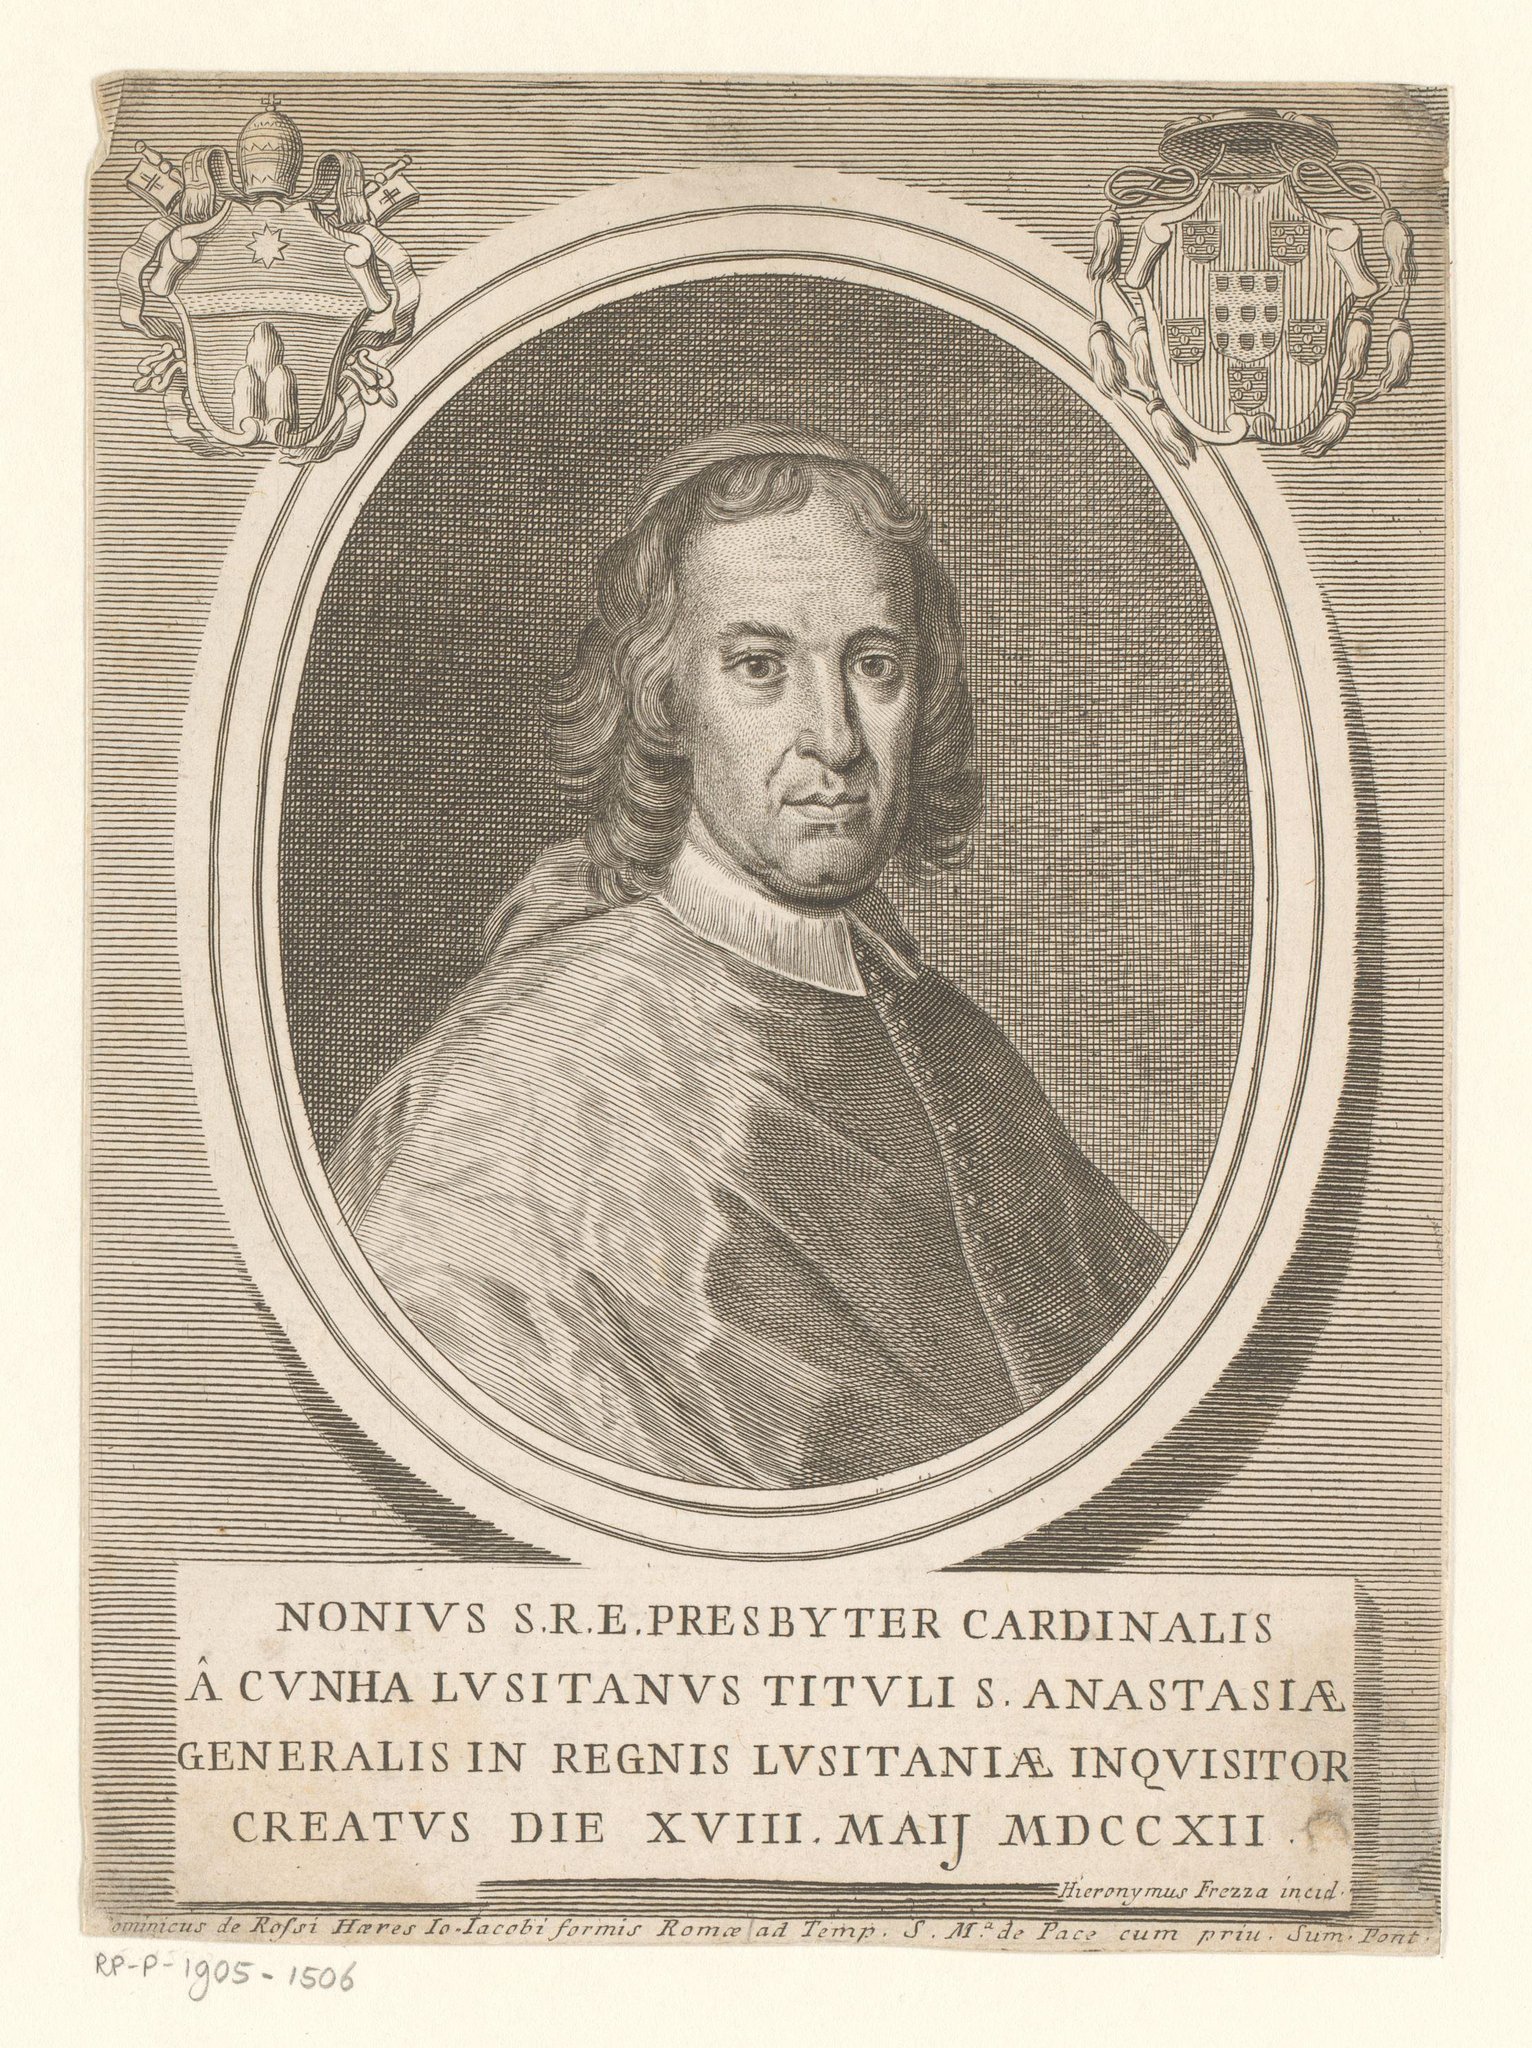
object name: print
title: Effigies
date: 1686-1748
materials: paper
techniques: engraving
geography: vatican city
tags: cardinal, historical persons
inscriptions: collector's mark: Lugt 2228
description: Prent uit een reeks van onbekende omvang met portretten van kardinalen. De prenten werden vanaf 1657 vervaardigd in opdracht van uitgever Giovanni Giacomo de’ Rossi, waarna de productie werd voortgezet onder leiding van zijn opvolgers Domenico de’ Rossi en Lorenzo Filippo de’ Rossi, en tenslotte onder leiding van de Calcographia R.C.A.